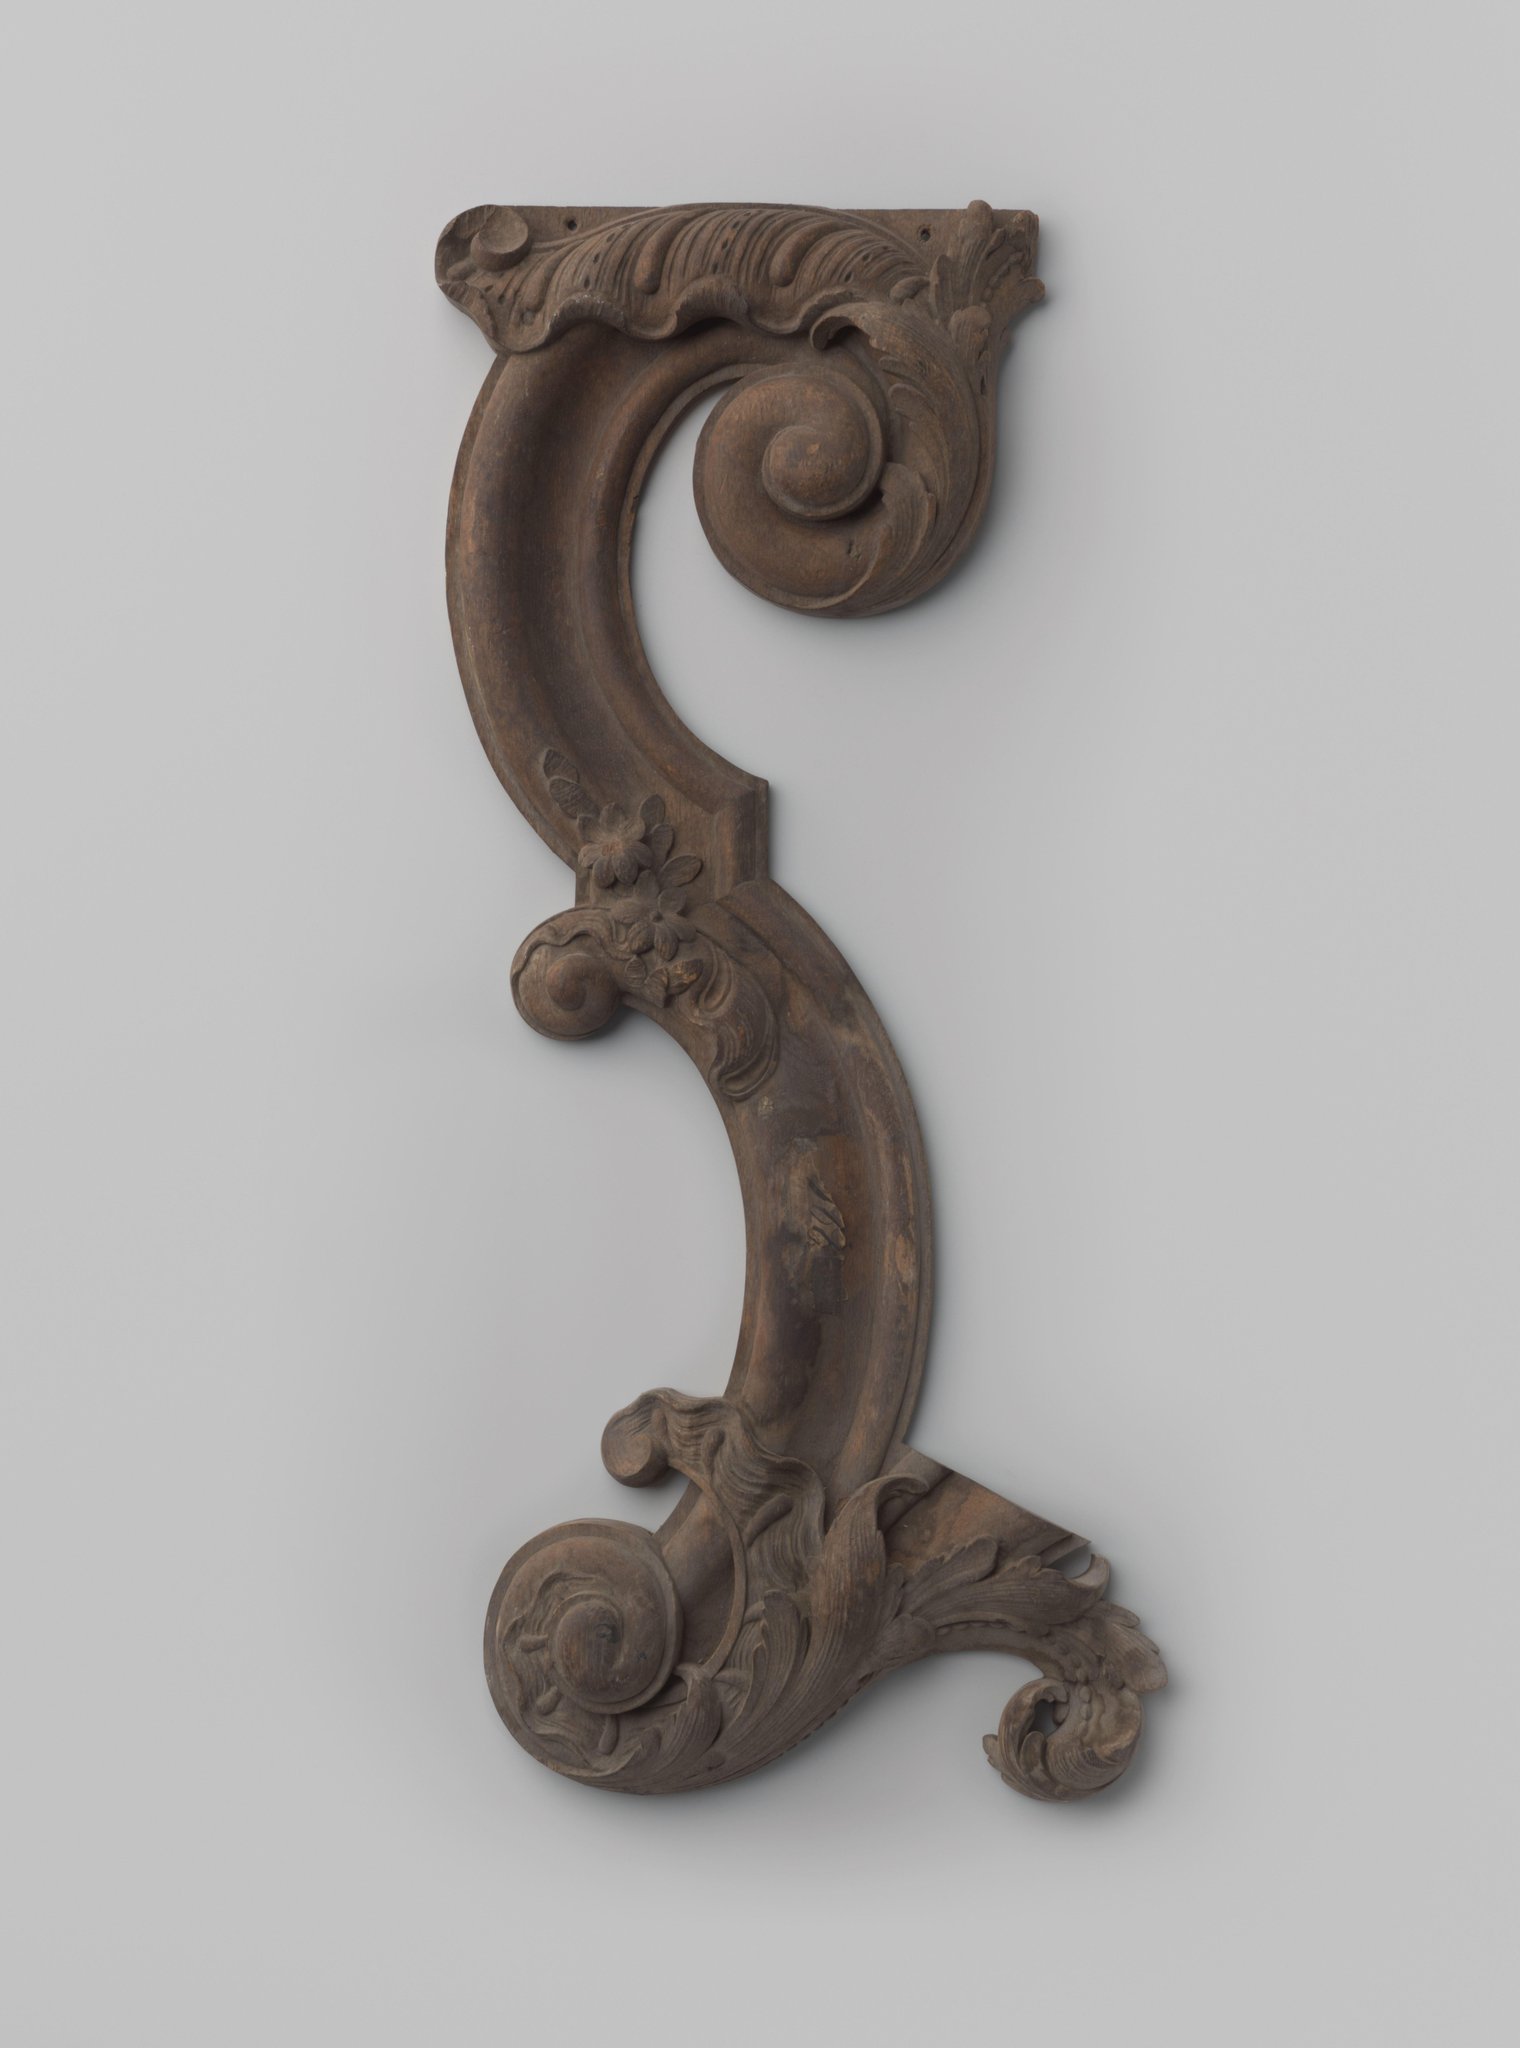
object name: decoration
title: Bouwfragment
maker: Anonymous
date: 1400-1950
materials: wood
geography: netherlands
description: Fragment van gebeeldhouwd eikenhouten lijstwerk, krul van een lambrisering in 'S'-vorm, versierd met blad-, krul- en bloemornamenten.